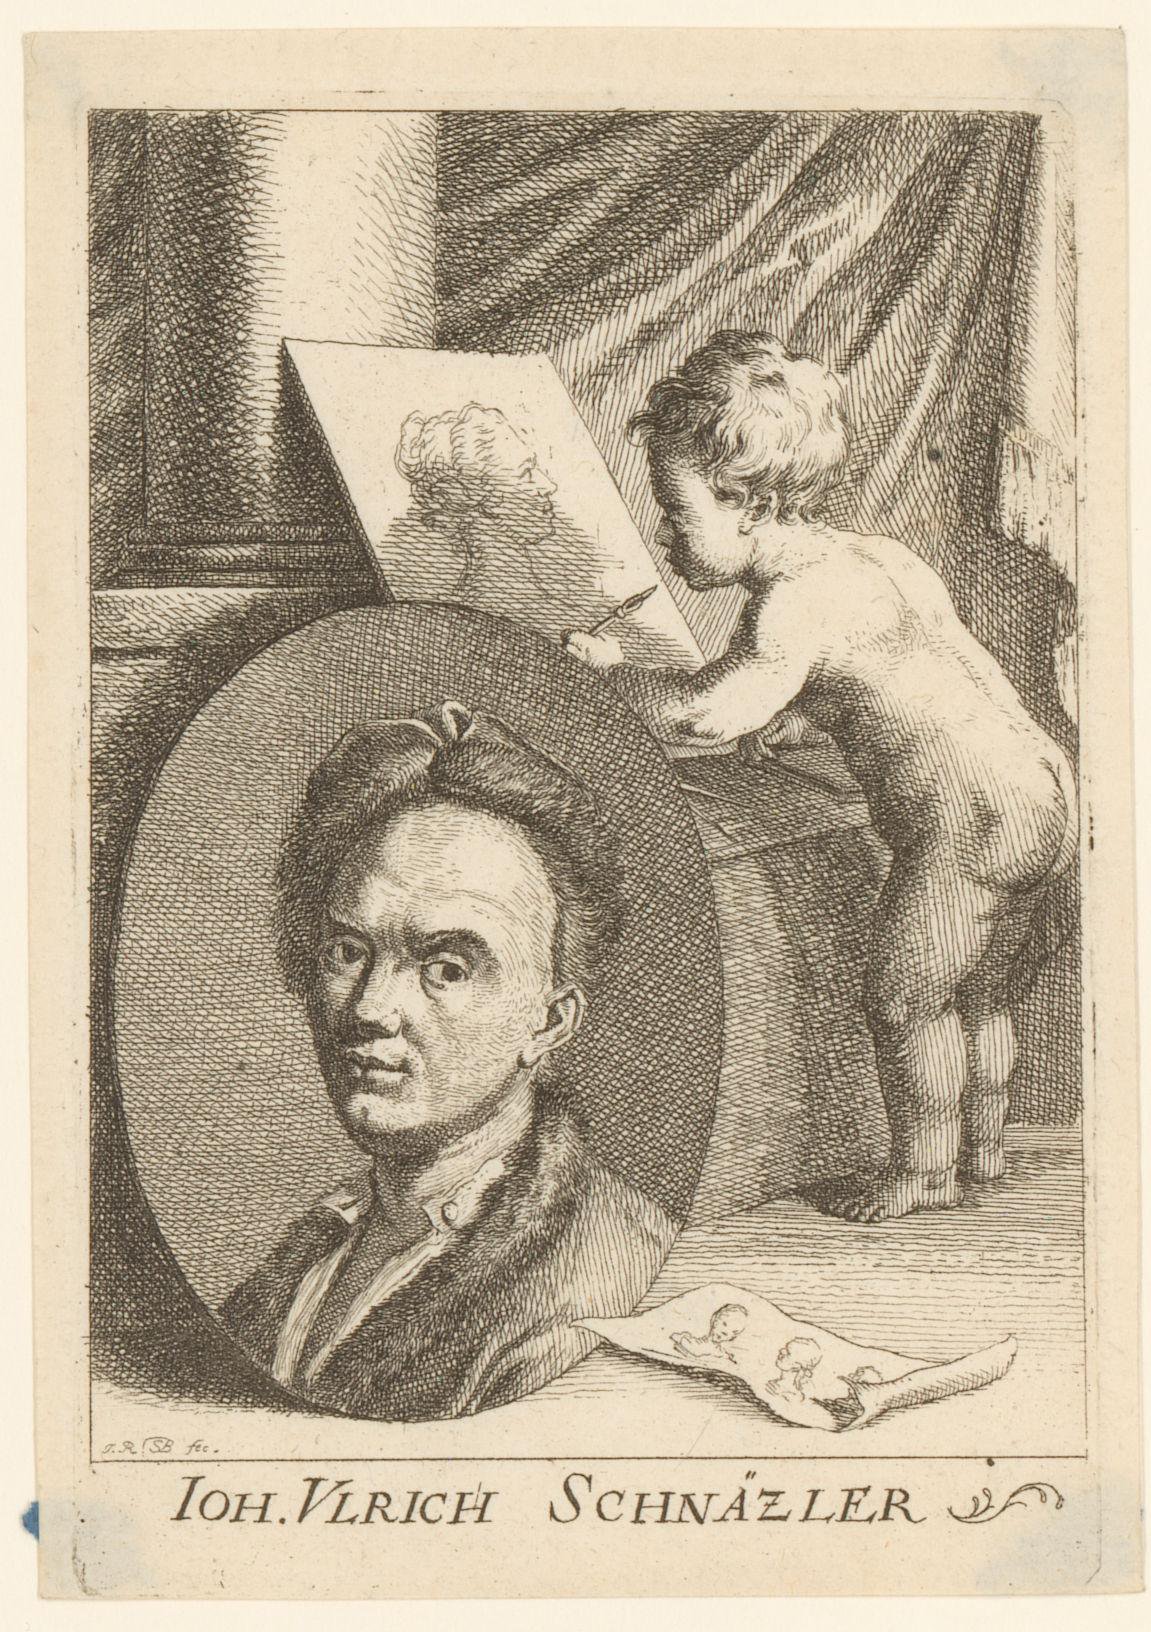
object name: print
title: Portret van Johann Ulrich Schnäzler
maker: johann rudolph schellenberg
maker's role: print maker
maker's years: 1740-1806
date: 1750-1806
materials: paper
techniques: etching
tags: draughtsman, tools, implements of draughtsman, cupids: 'amores', 'amoretti', 'putti', portrait, self-portrait of draughtsman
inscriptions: collector's mark: Lugt 2228